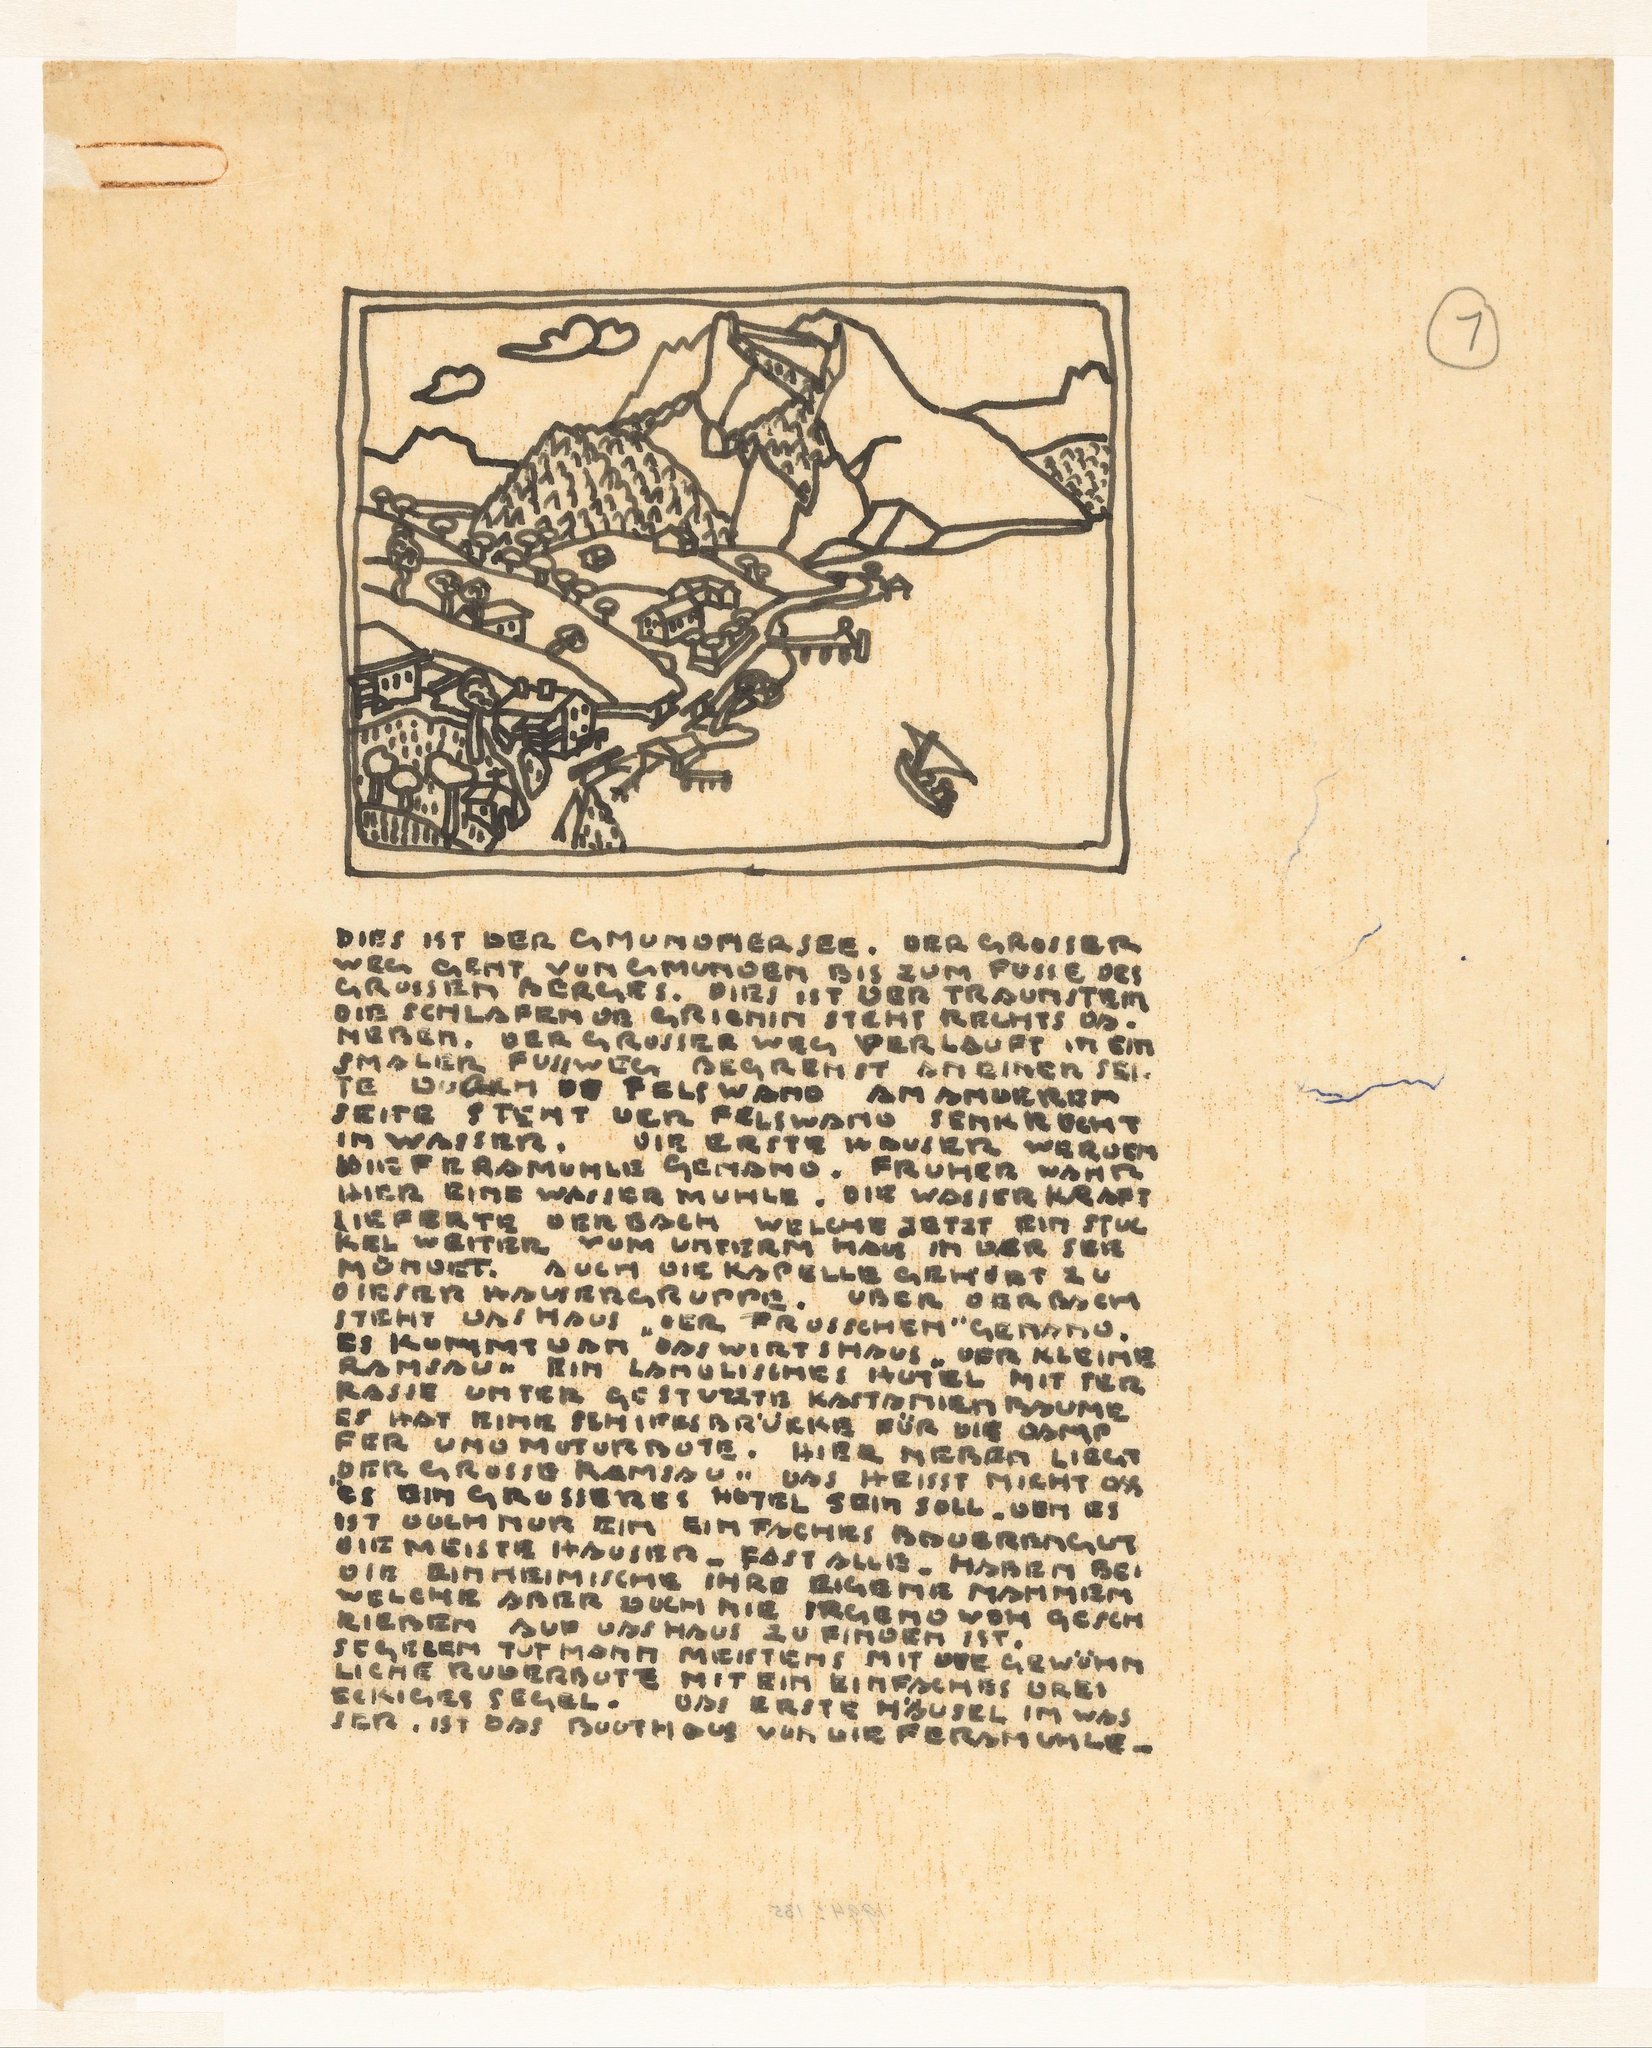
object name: text sheet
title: Gezicht op Traunsee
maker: reijer stolk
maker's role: draughtsman, print maker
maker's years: 1896-1945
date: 1922-1926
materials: ink, paper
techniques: pen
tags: lake, mountains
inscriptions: inscription: ‘7’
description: Deze tekening is mogelijk een ontwerp voor een tekstblad met boekillustratie.